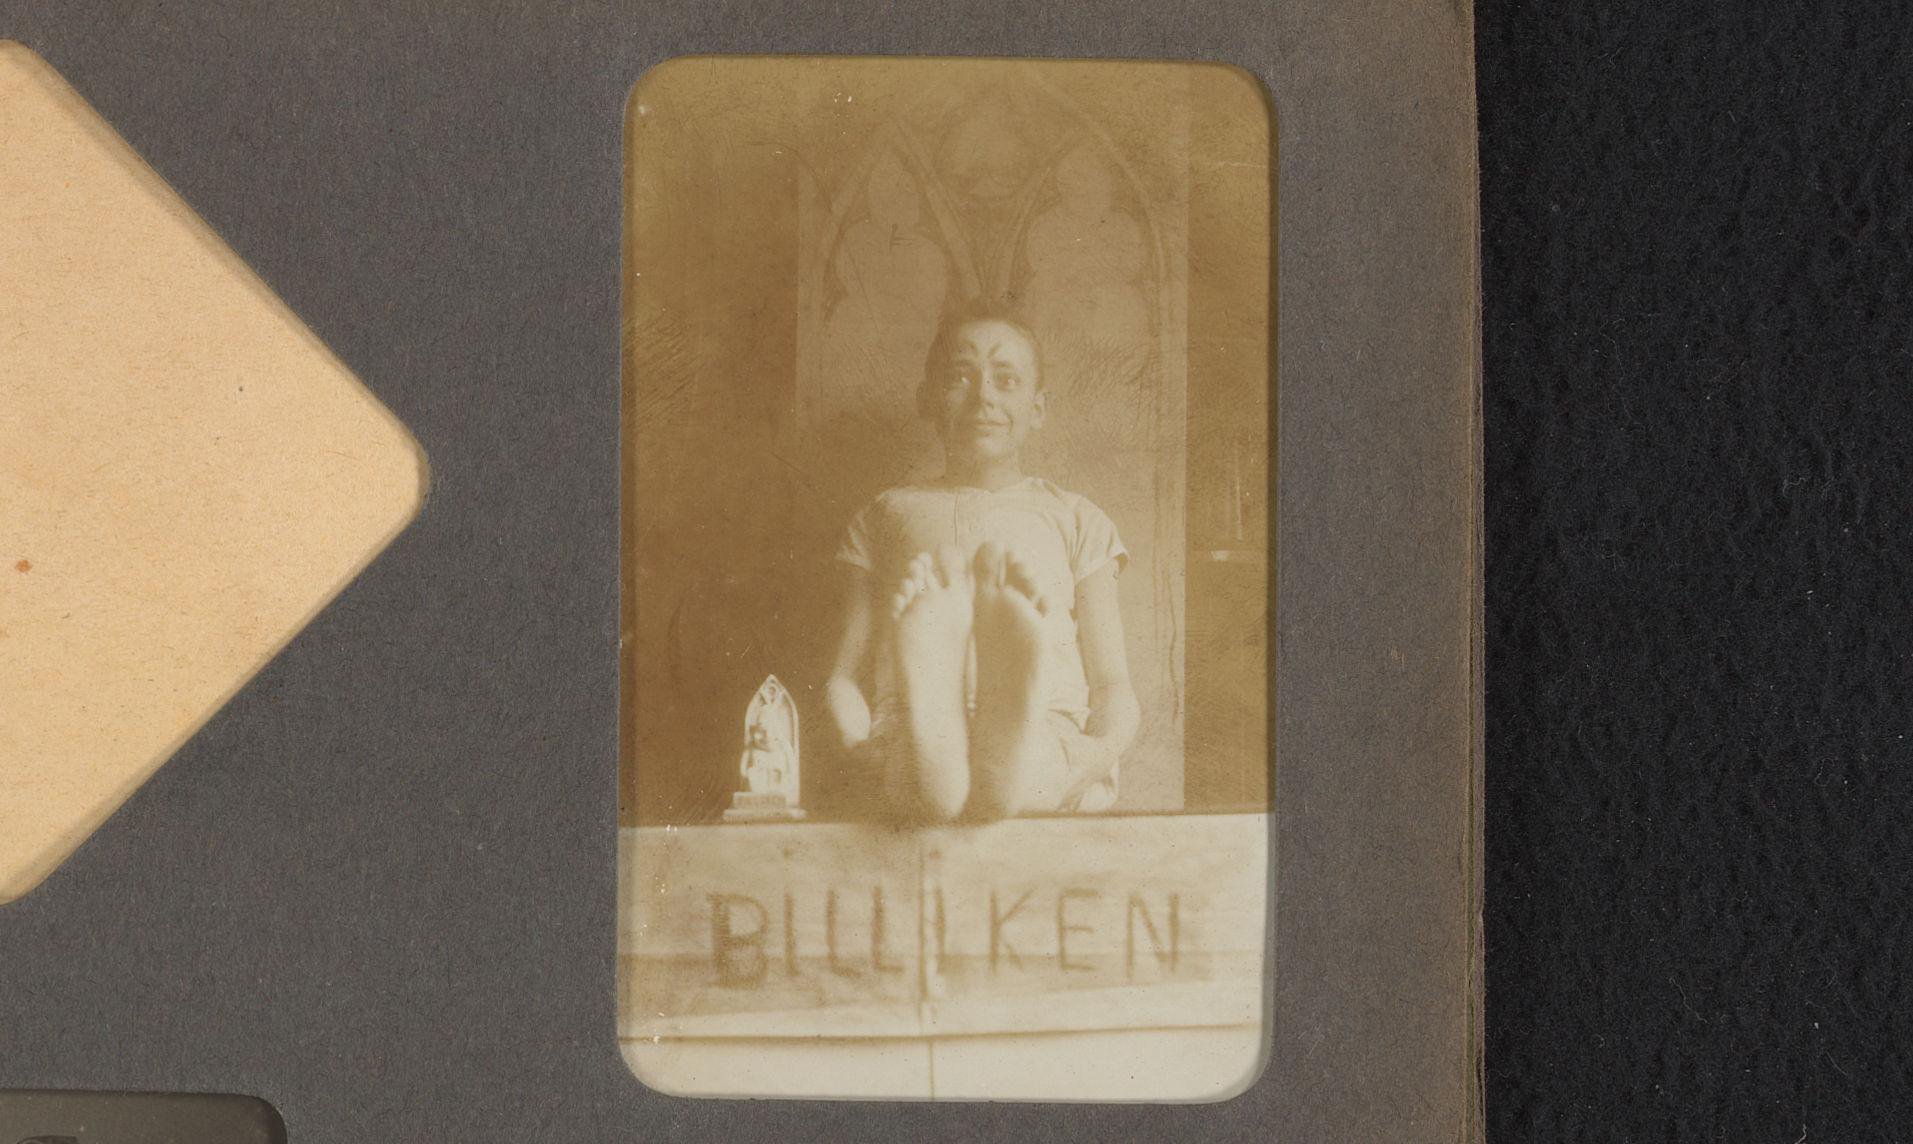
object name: photograph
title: Portret van een kind in dezelfde pose als de Billiken pop op tafel ernaast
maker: Anonymous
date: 1908-1912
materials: paper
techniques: gelatin silver print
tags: anonymous historical person portrayed, child (at home)